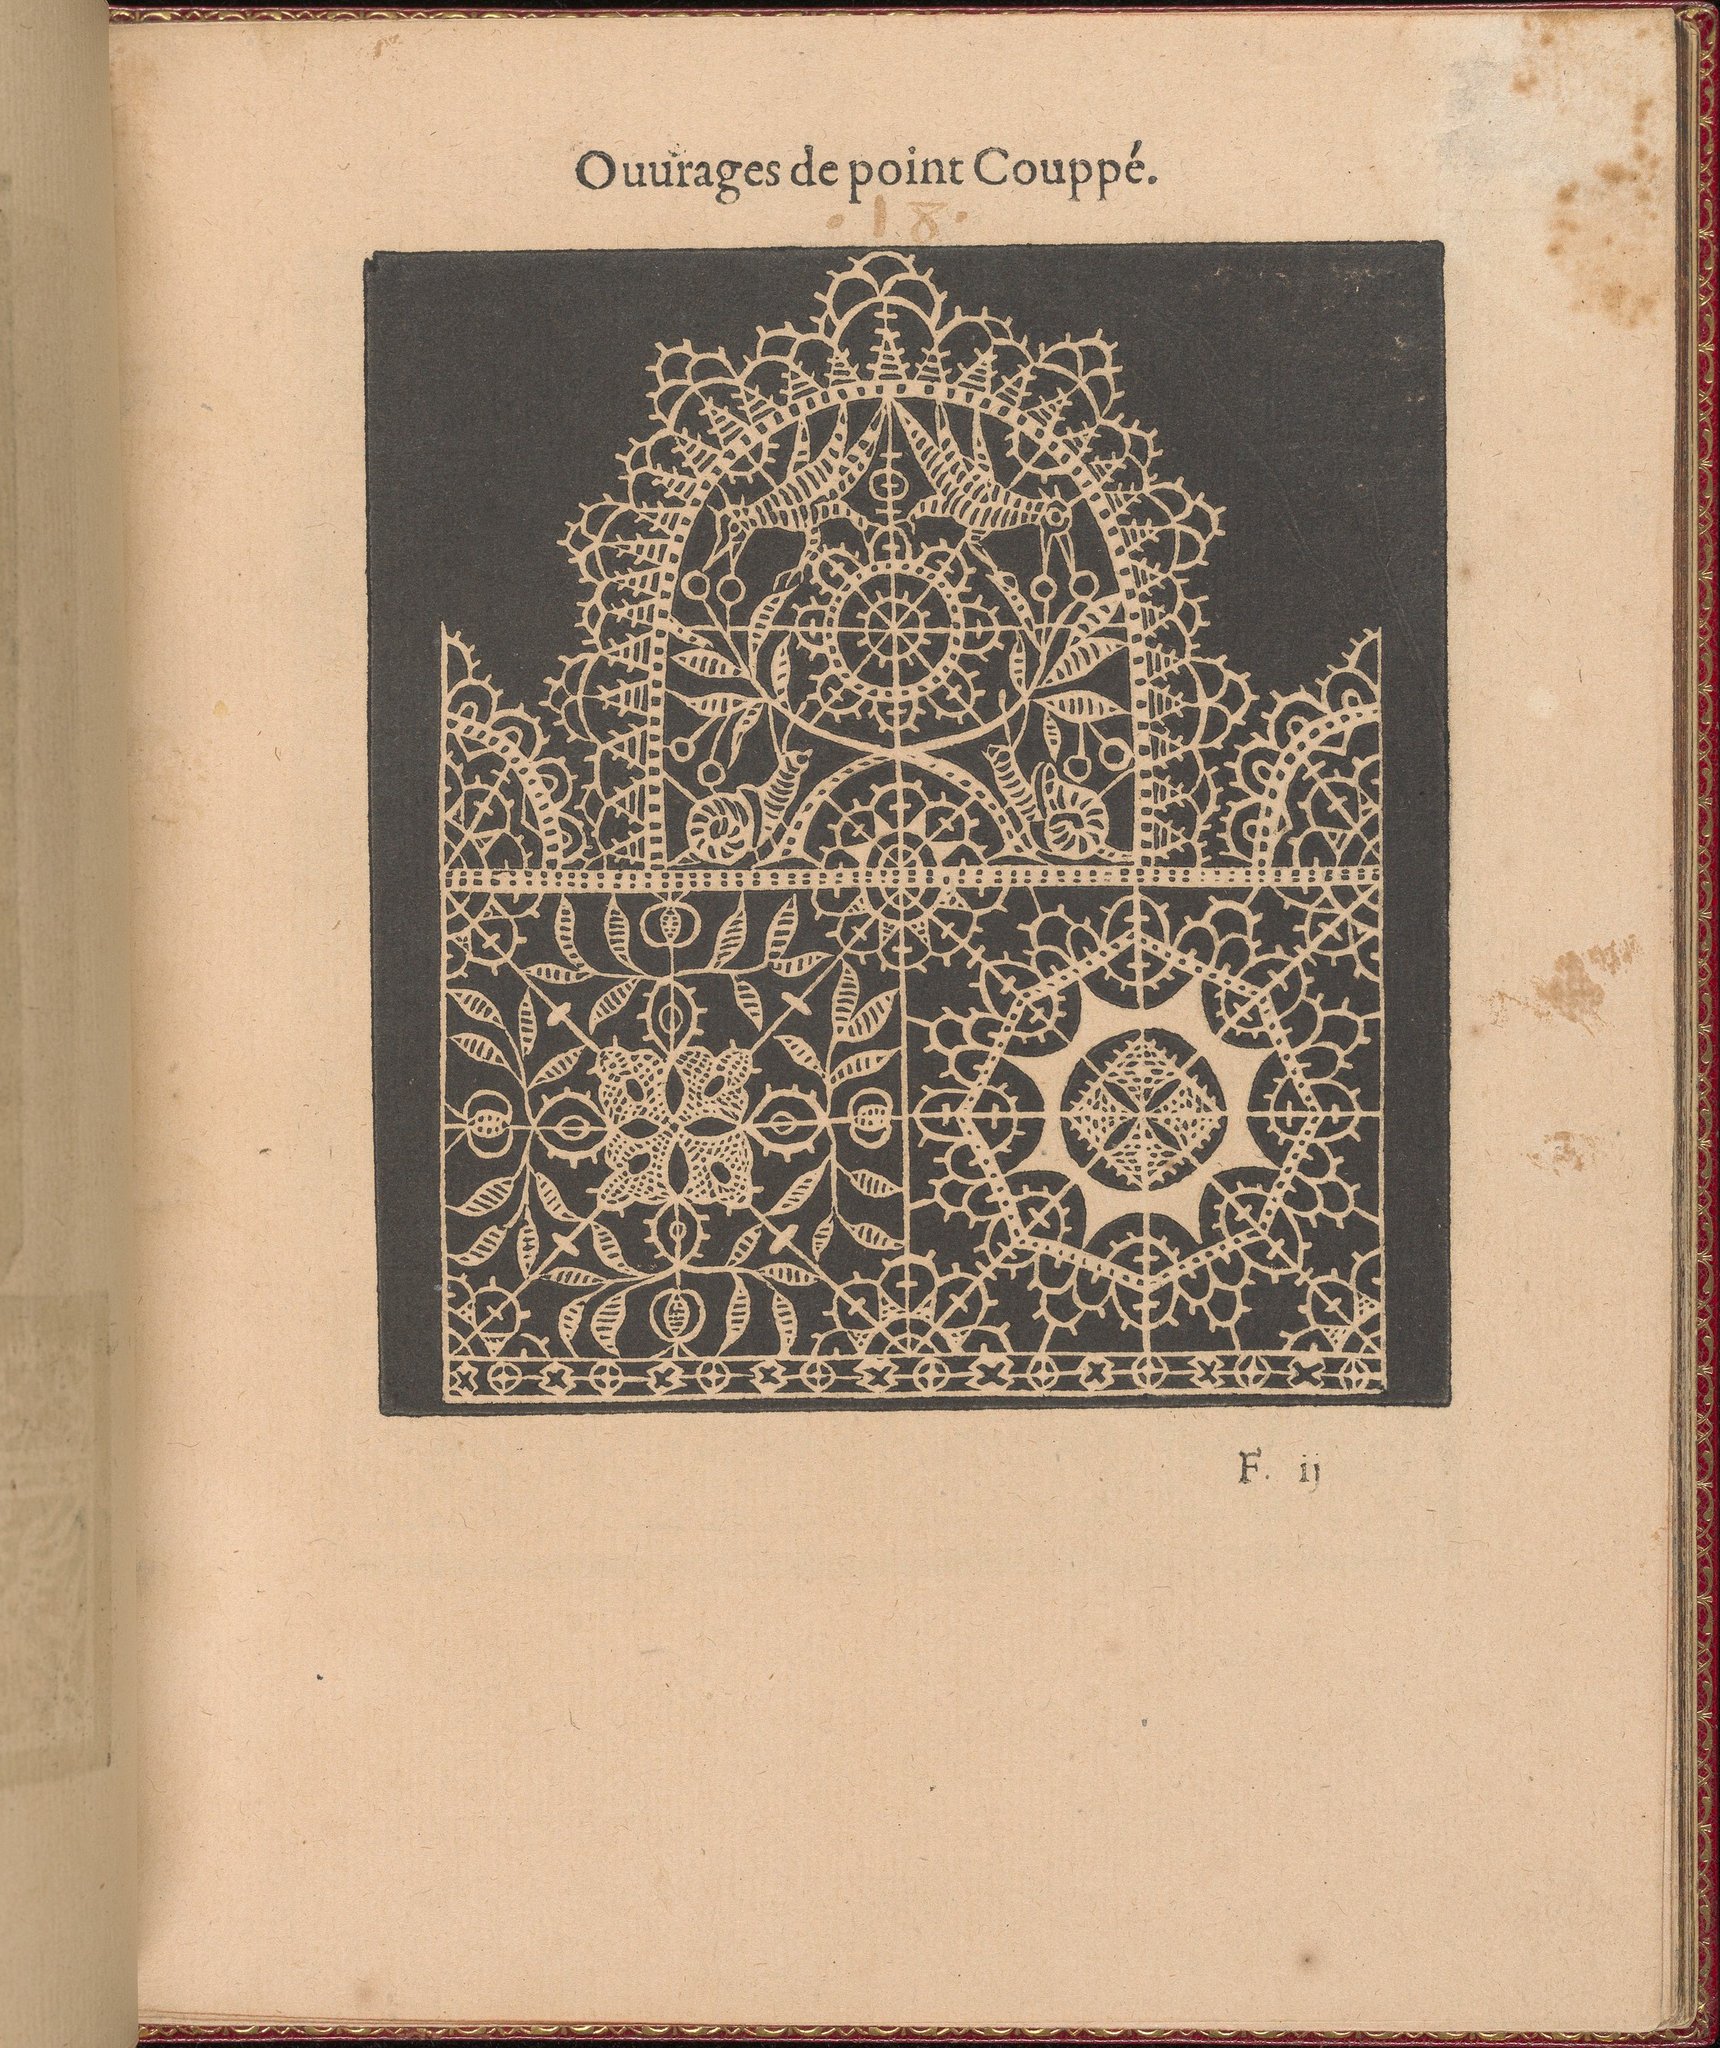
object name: book print ornament architecture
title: Les Singuliers et Nouveaux Portraicts... page 22 (recto)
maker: federico de vinciolo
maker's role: designer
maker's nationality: italian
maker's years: 1582-1599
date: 1588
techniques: woodcut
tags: birds,snails